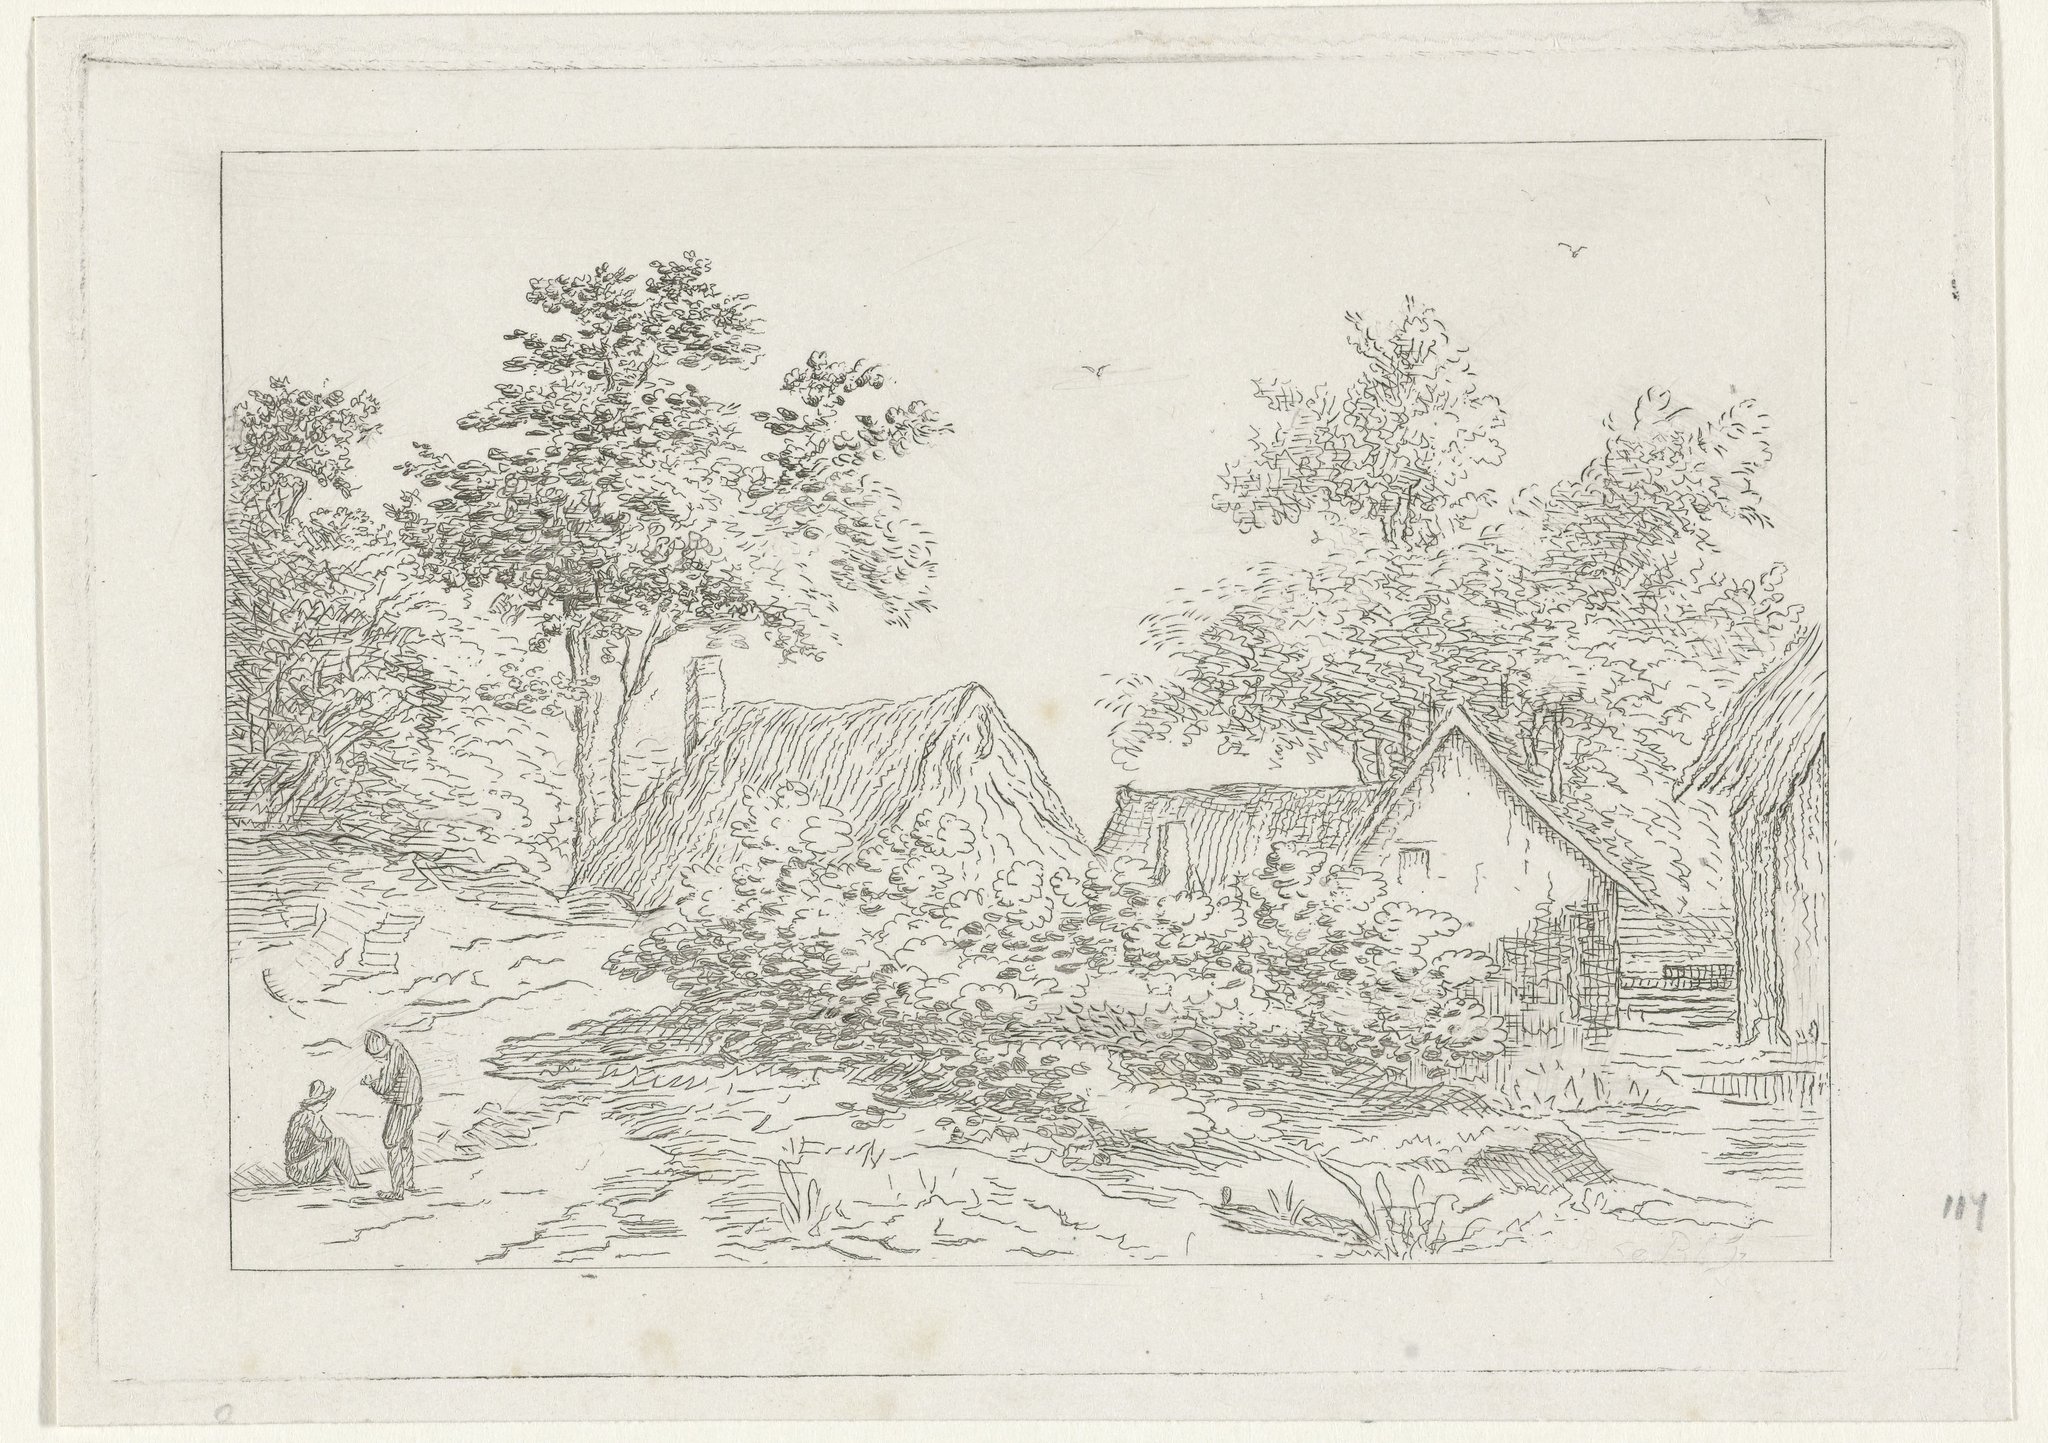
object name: print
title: Landschap met boerderijen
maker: reinierus albertus ludovicus baron van isendoorn à blois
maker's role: print maker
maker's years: 1786-1856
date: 1796-1856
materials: paper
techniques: etching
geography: vaassen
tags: farm or solitary house in landscape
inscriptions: collector's mark: Lugt 2228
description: Drie boerderijen tussen de bomen. Op de voorgrond struikgewas en links twee figuren.